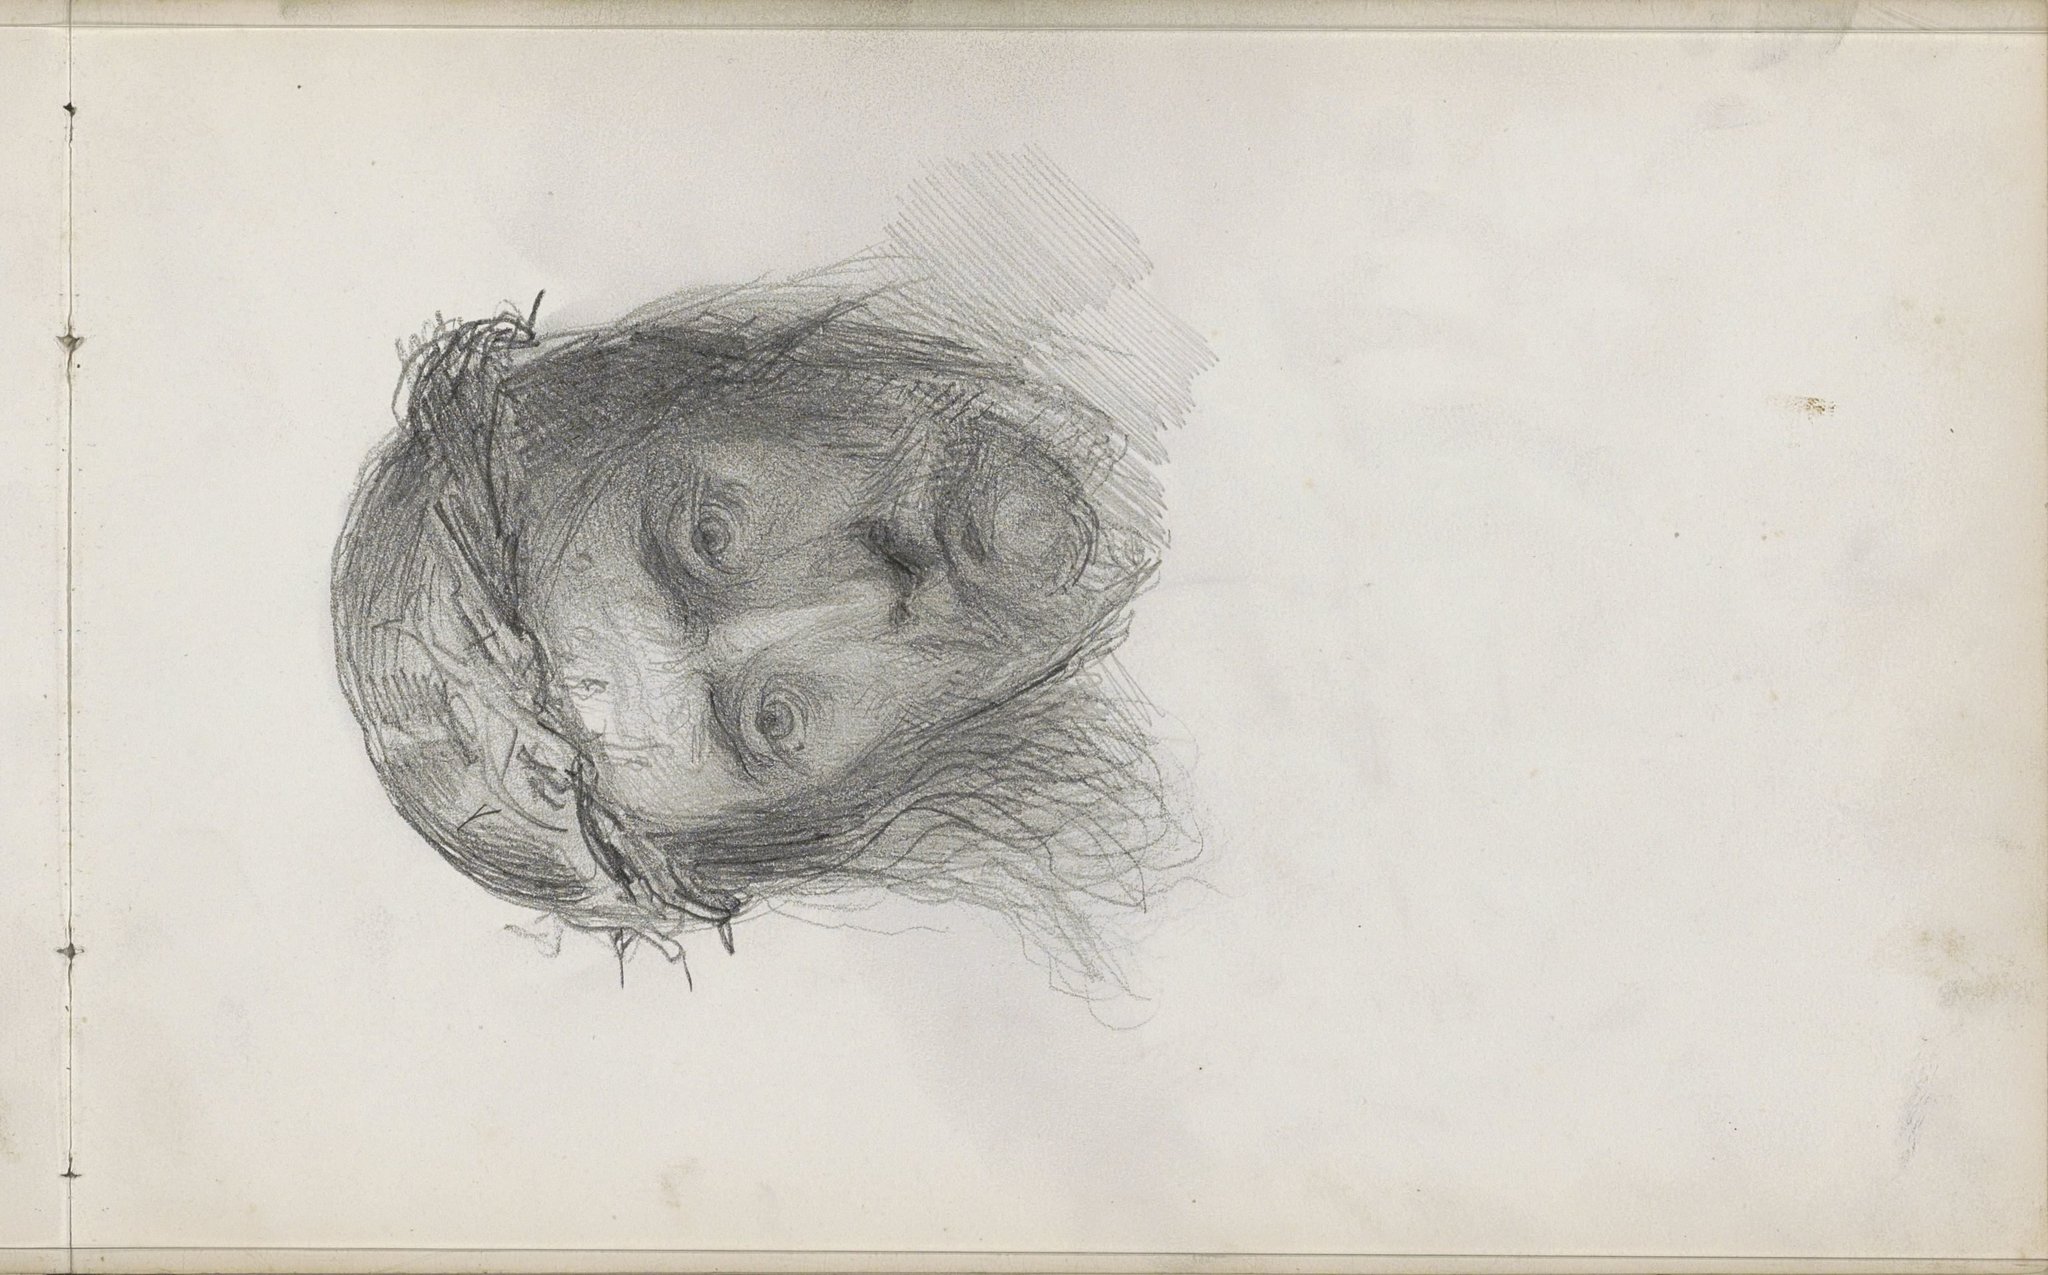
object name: sketchbook leaf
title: Hoofd van Christus met doornenkroon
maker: bastiaan de poorter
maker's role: painter, print maker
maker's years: 1813-1880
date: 1858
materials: paper, pencil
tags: head of christ with crown of thorns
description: Blad 18 recto uit een gecombineerd album amicorum en schetsboek met in totaal 39 bladen.